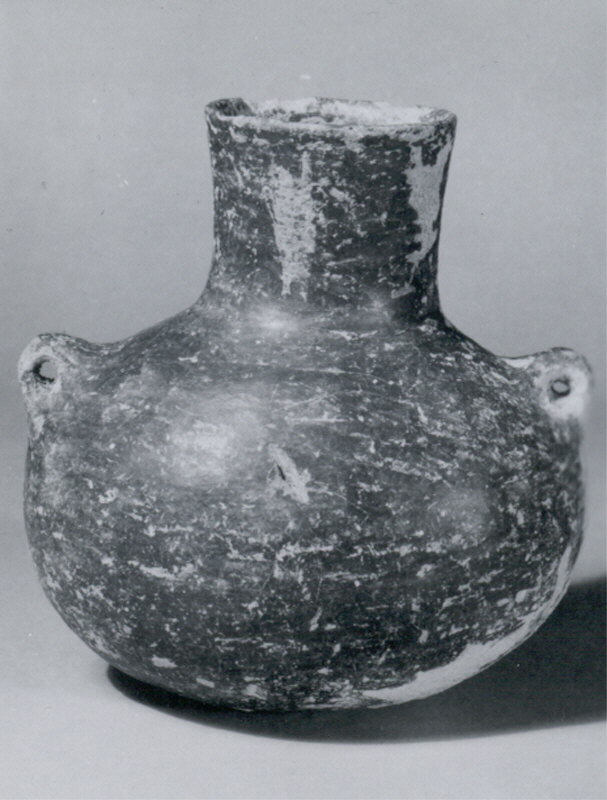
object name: jar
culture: hacilar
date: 6000-5400 BCE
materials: ceramic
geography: southwestern anatolia